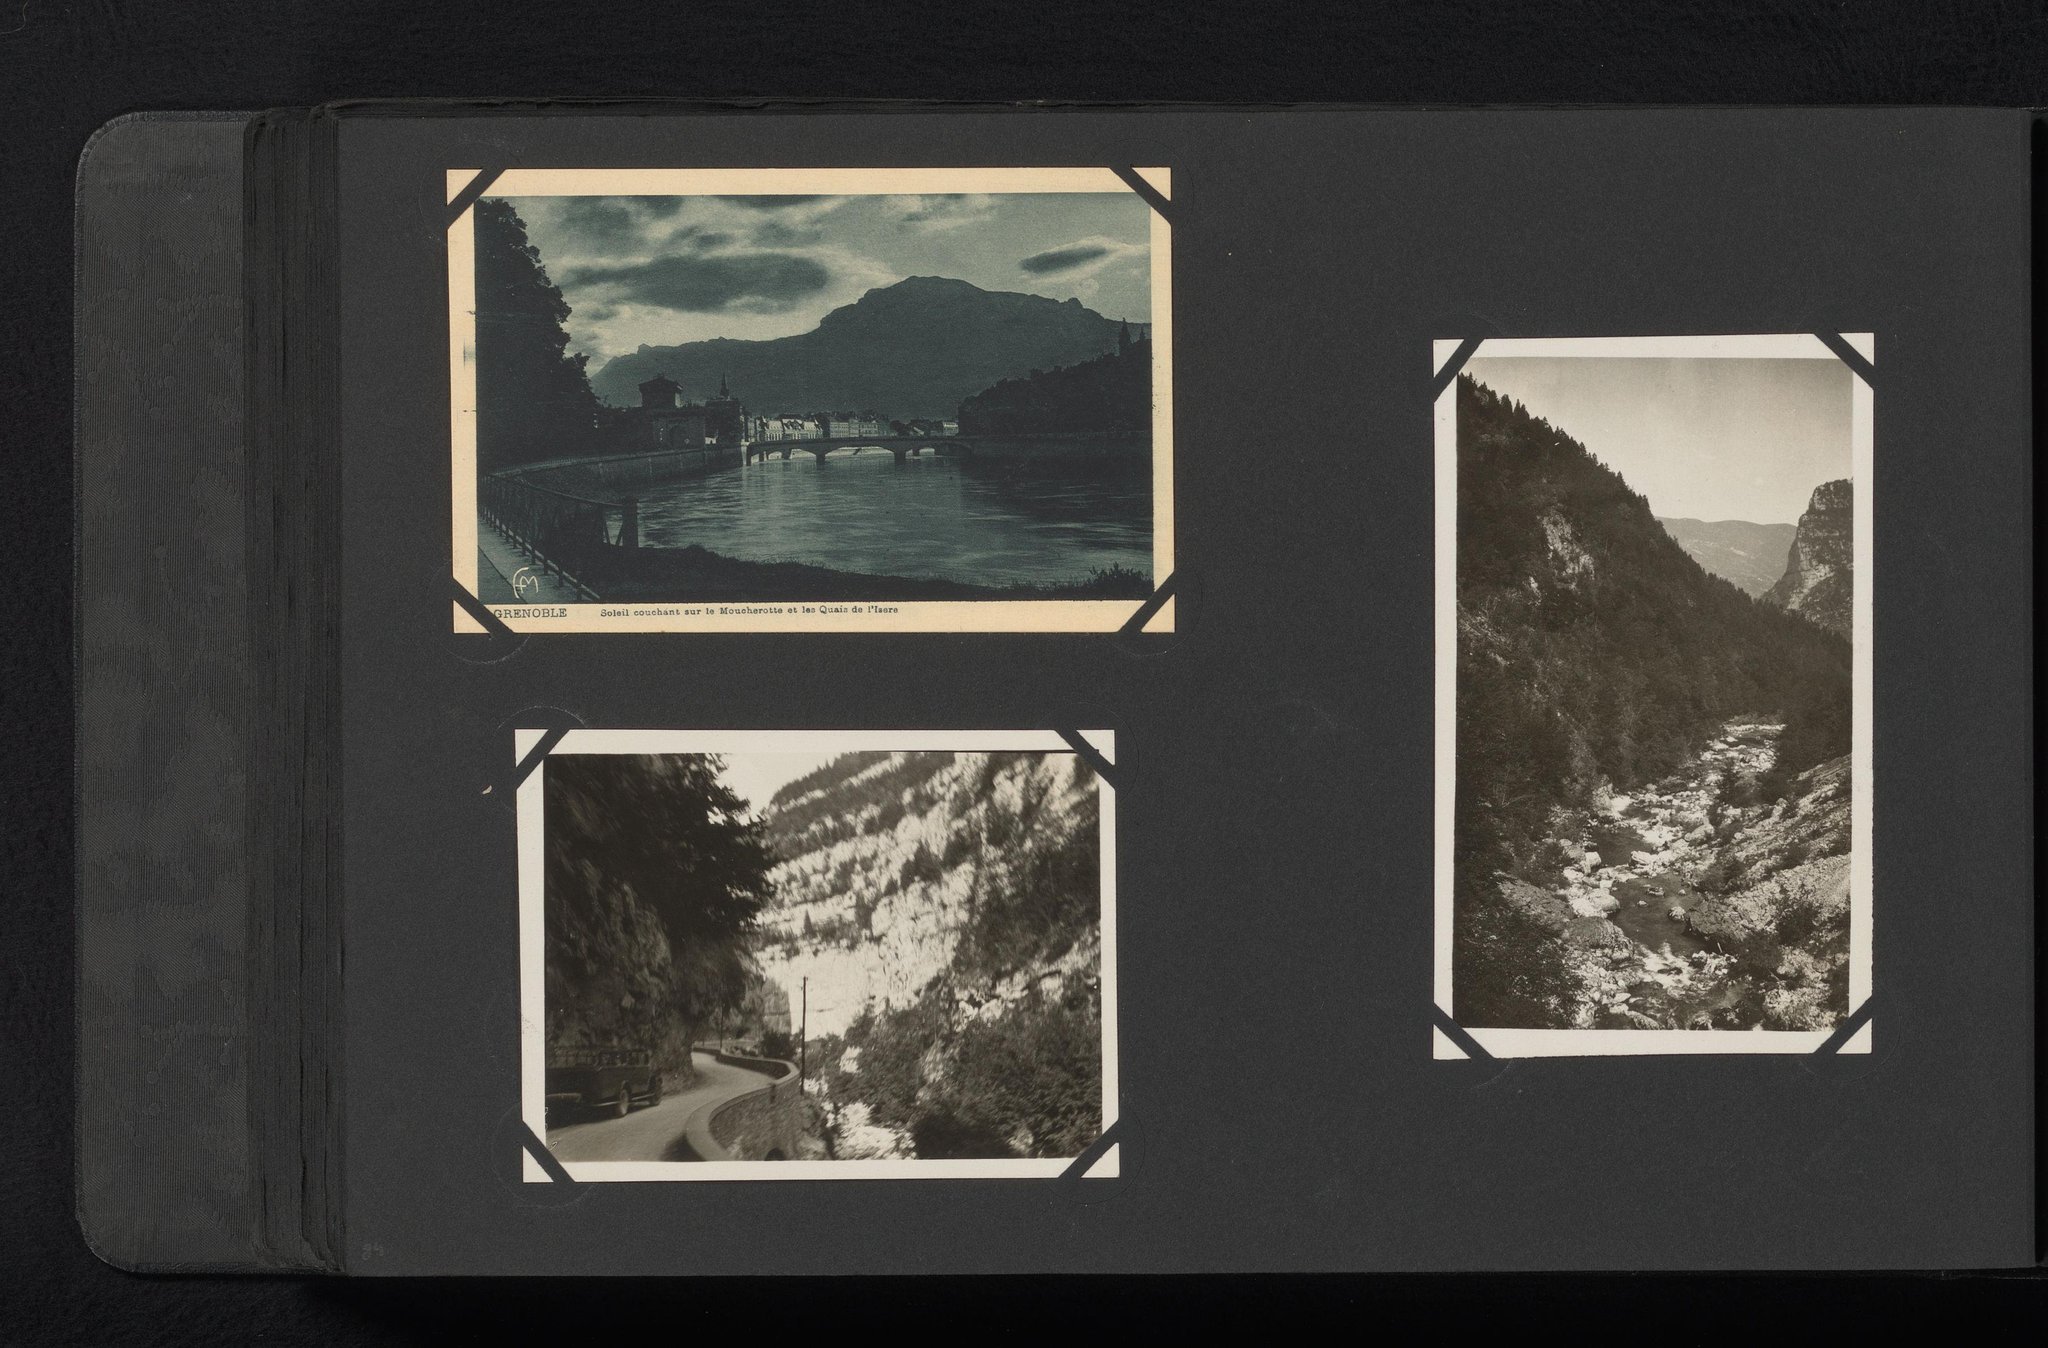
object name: photomechanical print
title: Twee foto's en een fotomechanische prentbriefkaart van Grenoble en omgeving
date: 1908-1929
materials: paper, cardboard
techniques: gelatin silver print, rotogravure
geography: grenoble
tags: city-view in general; 'veduta', mountains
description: Deze prent en foto's maken deel uit van een album.